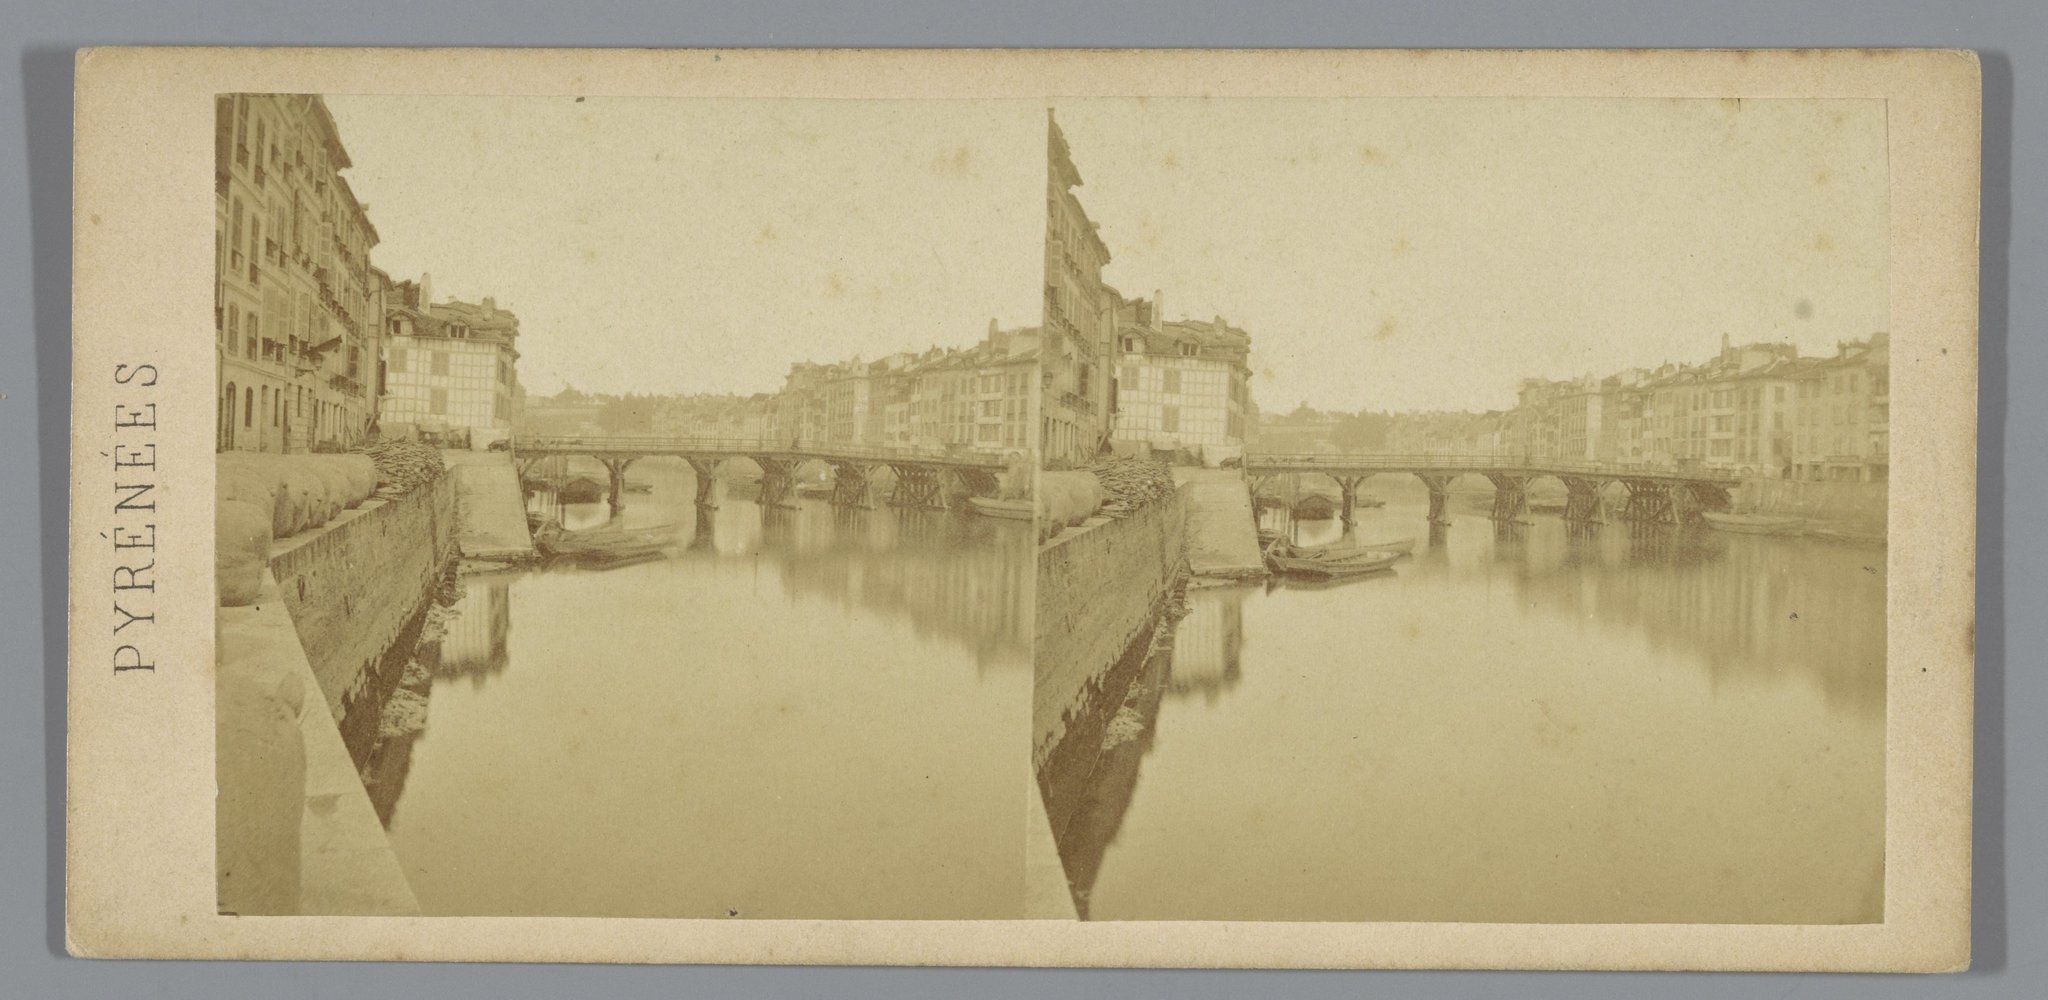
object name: stereograph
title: Pyrénées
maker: Anonymous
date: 1855-1865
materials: cardboard, photographic support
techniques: albumen print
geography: bayonne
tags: river, bridge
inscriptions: name: ‘J. C. Meerburg’, number: ‘169’